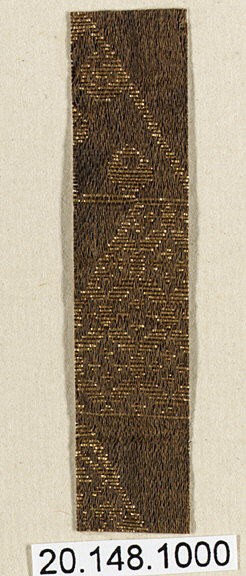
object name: piece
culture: japanese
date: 1801-1900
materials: silk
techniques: compound weave